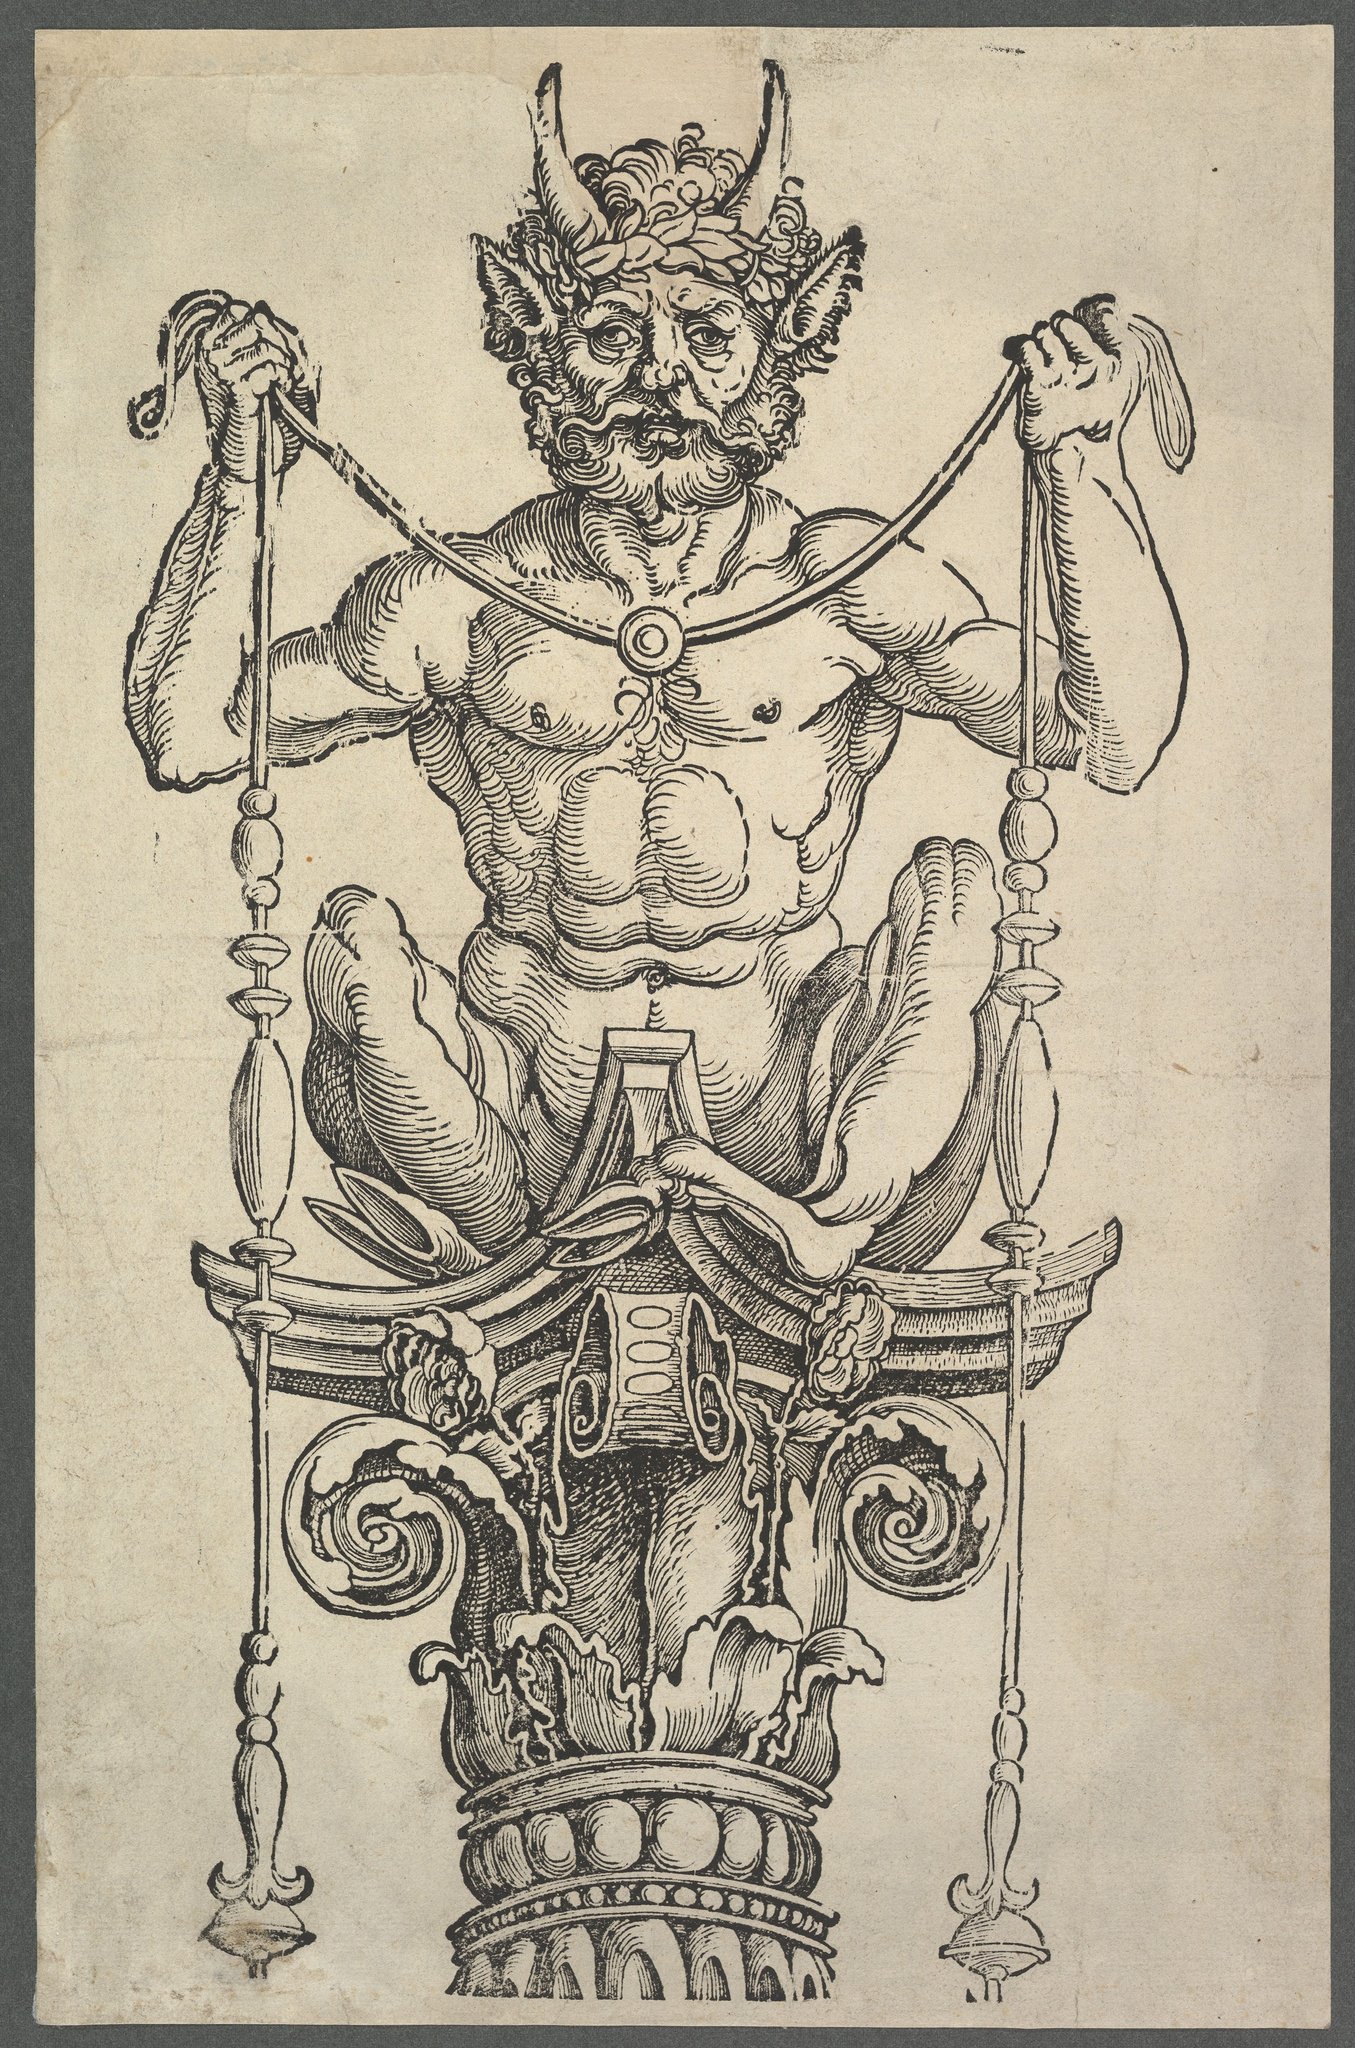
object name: print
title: The Great Column (top block)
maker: albrecht dürer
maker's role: artist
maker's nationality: german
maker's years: 1471-1528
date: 1517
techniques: woodcut